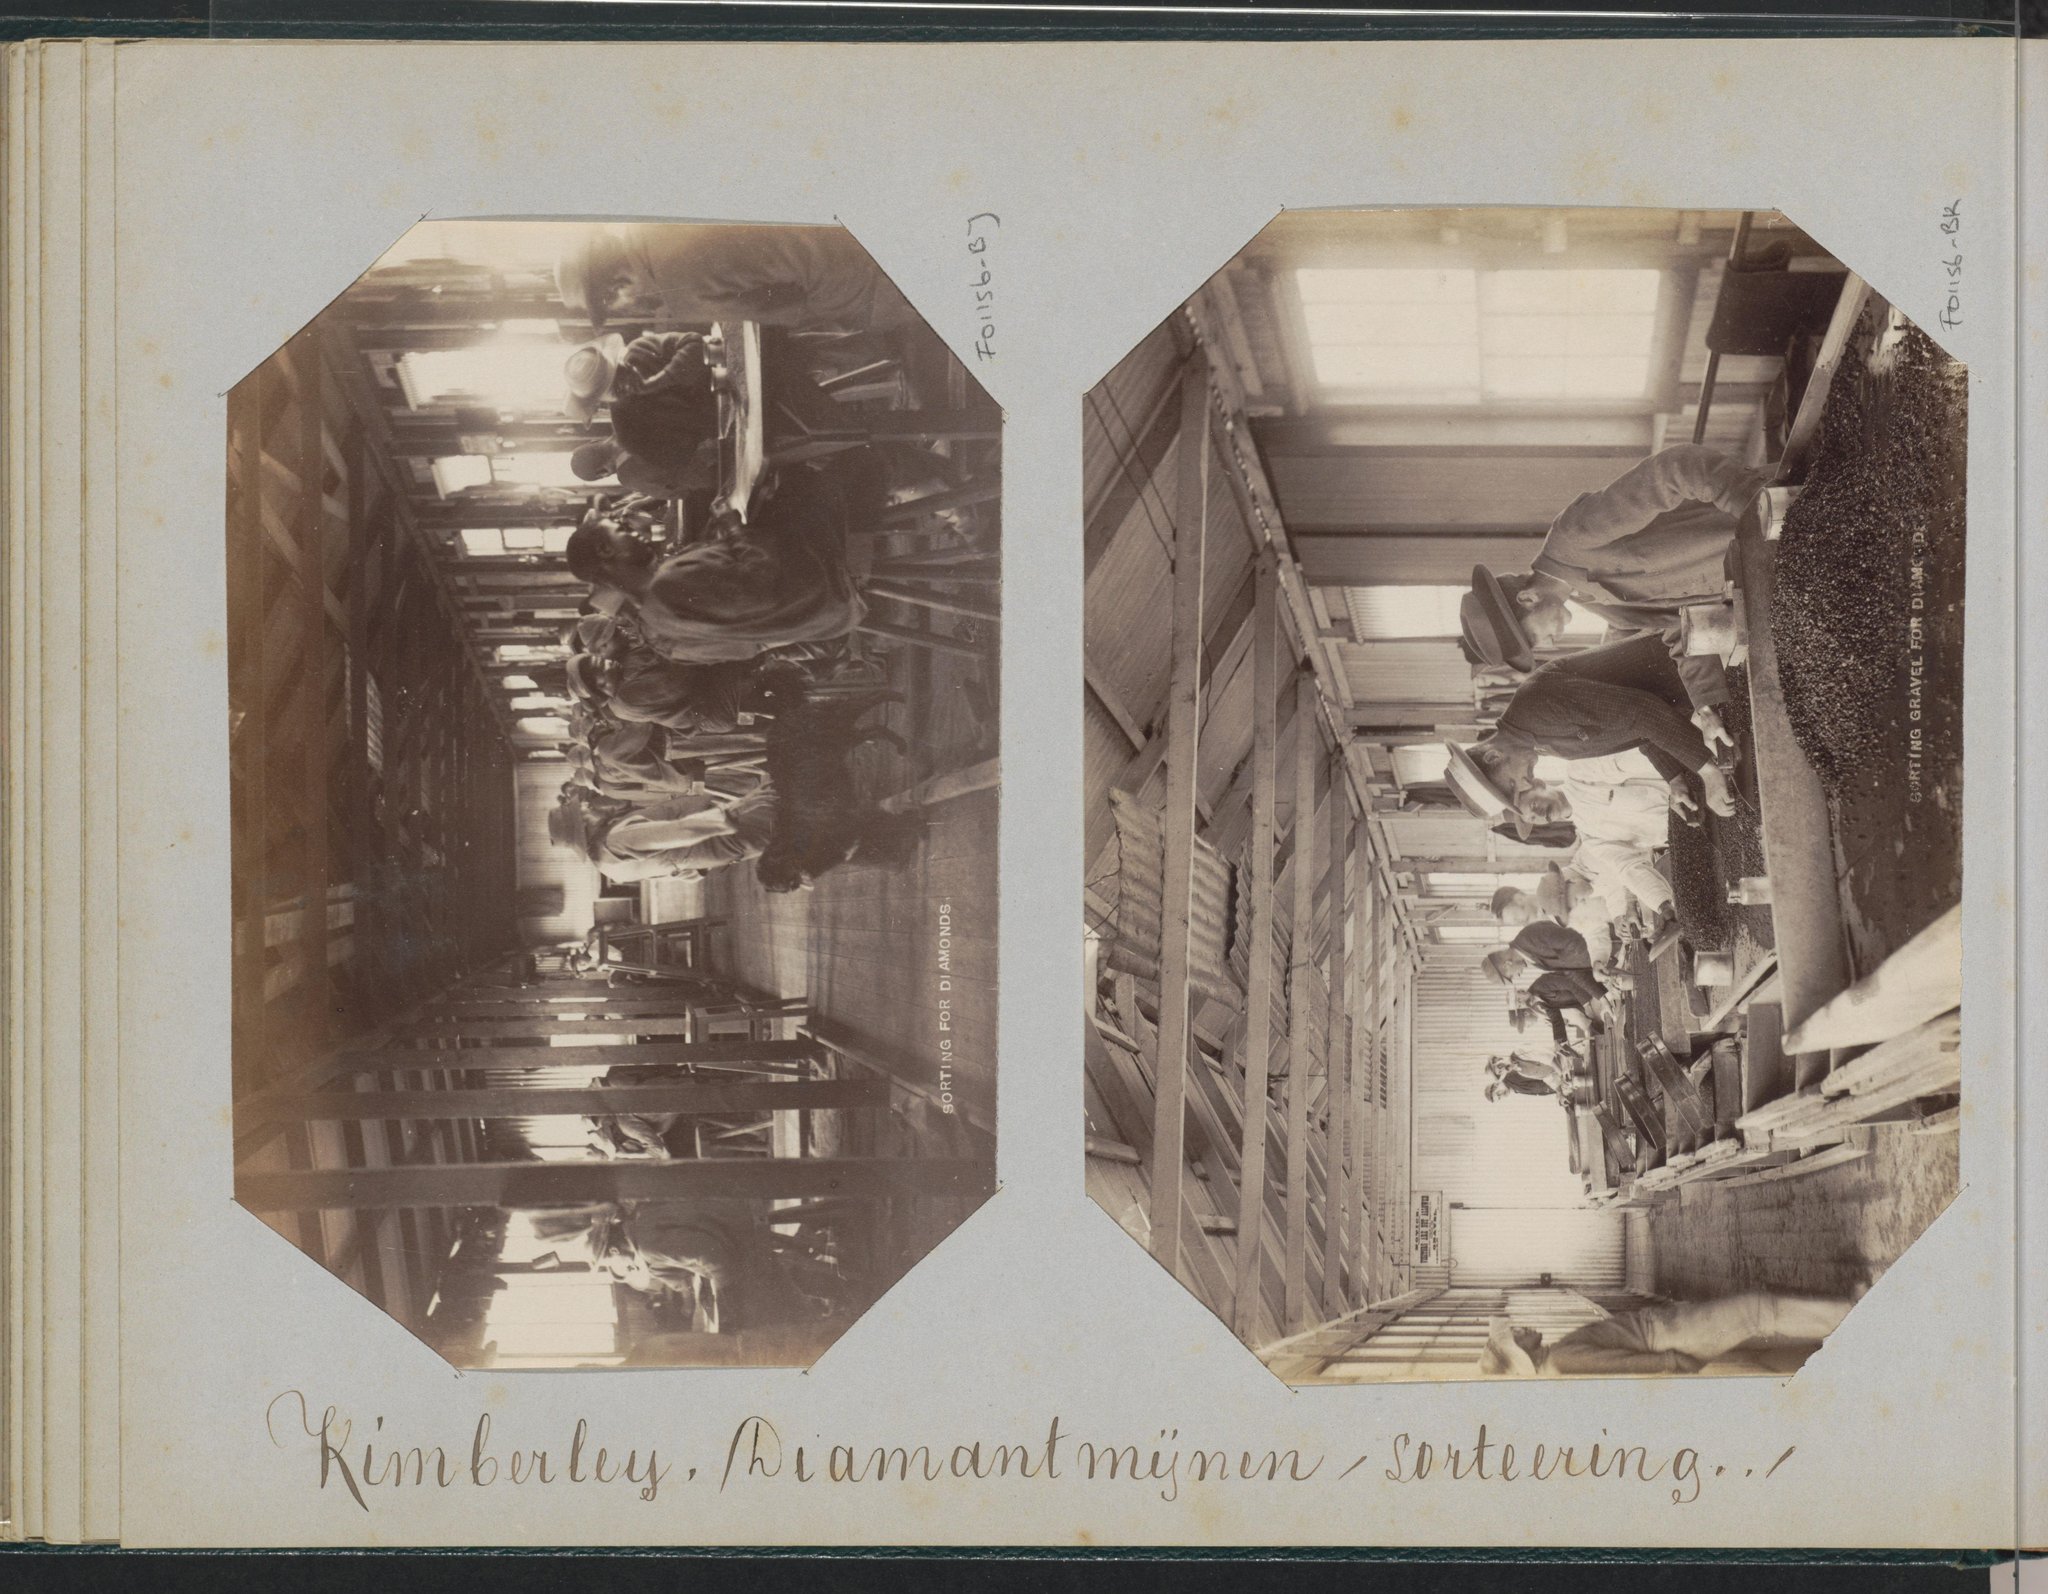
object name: photograph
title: Interieur van een hal waar gravel wordt gesorteerd op diamanten te Kimberley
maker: Anonymous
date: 1896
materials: photographic support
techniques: albumen print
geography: kimberley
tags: sorting of products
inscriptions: annotation: ‘Kimberley, Diamantmijnen, sorteering’, inscription: ‘Sorting gravel for diamonds’